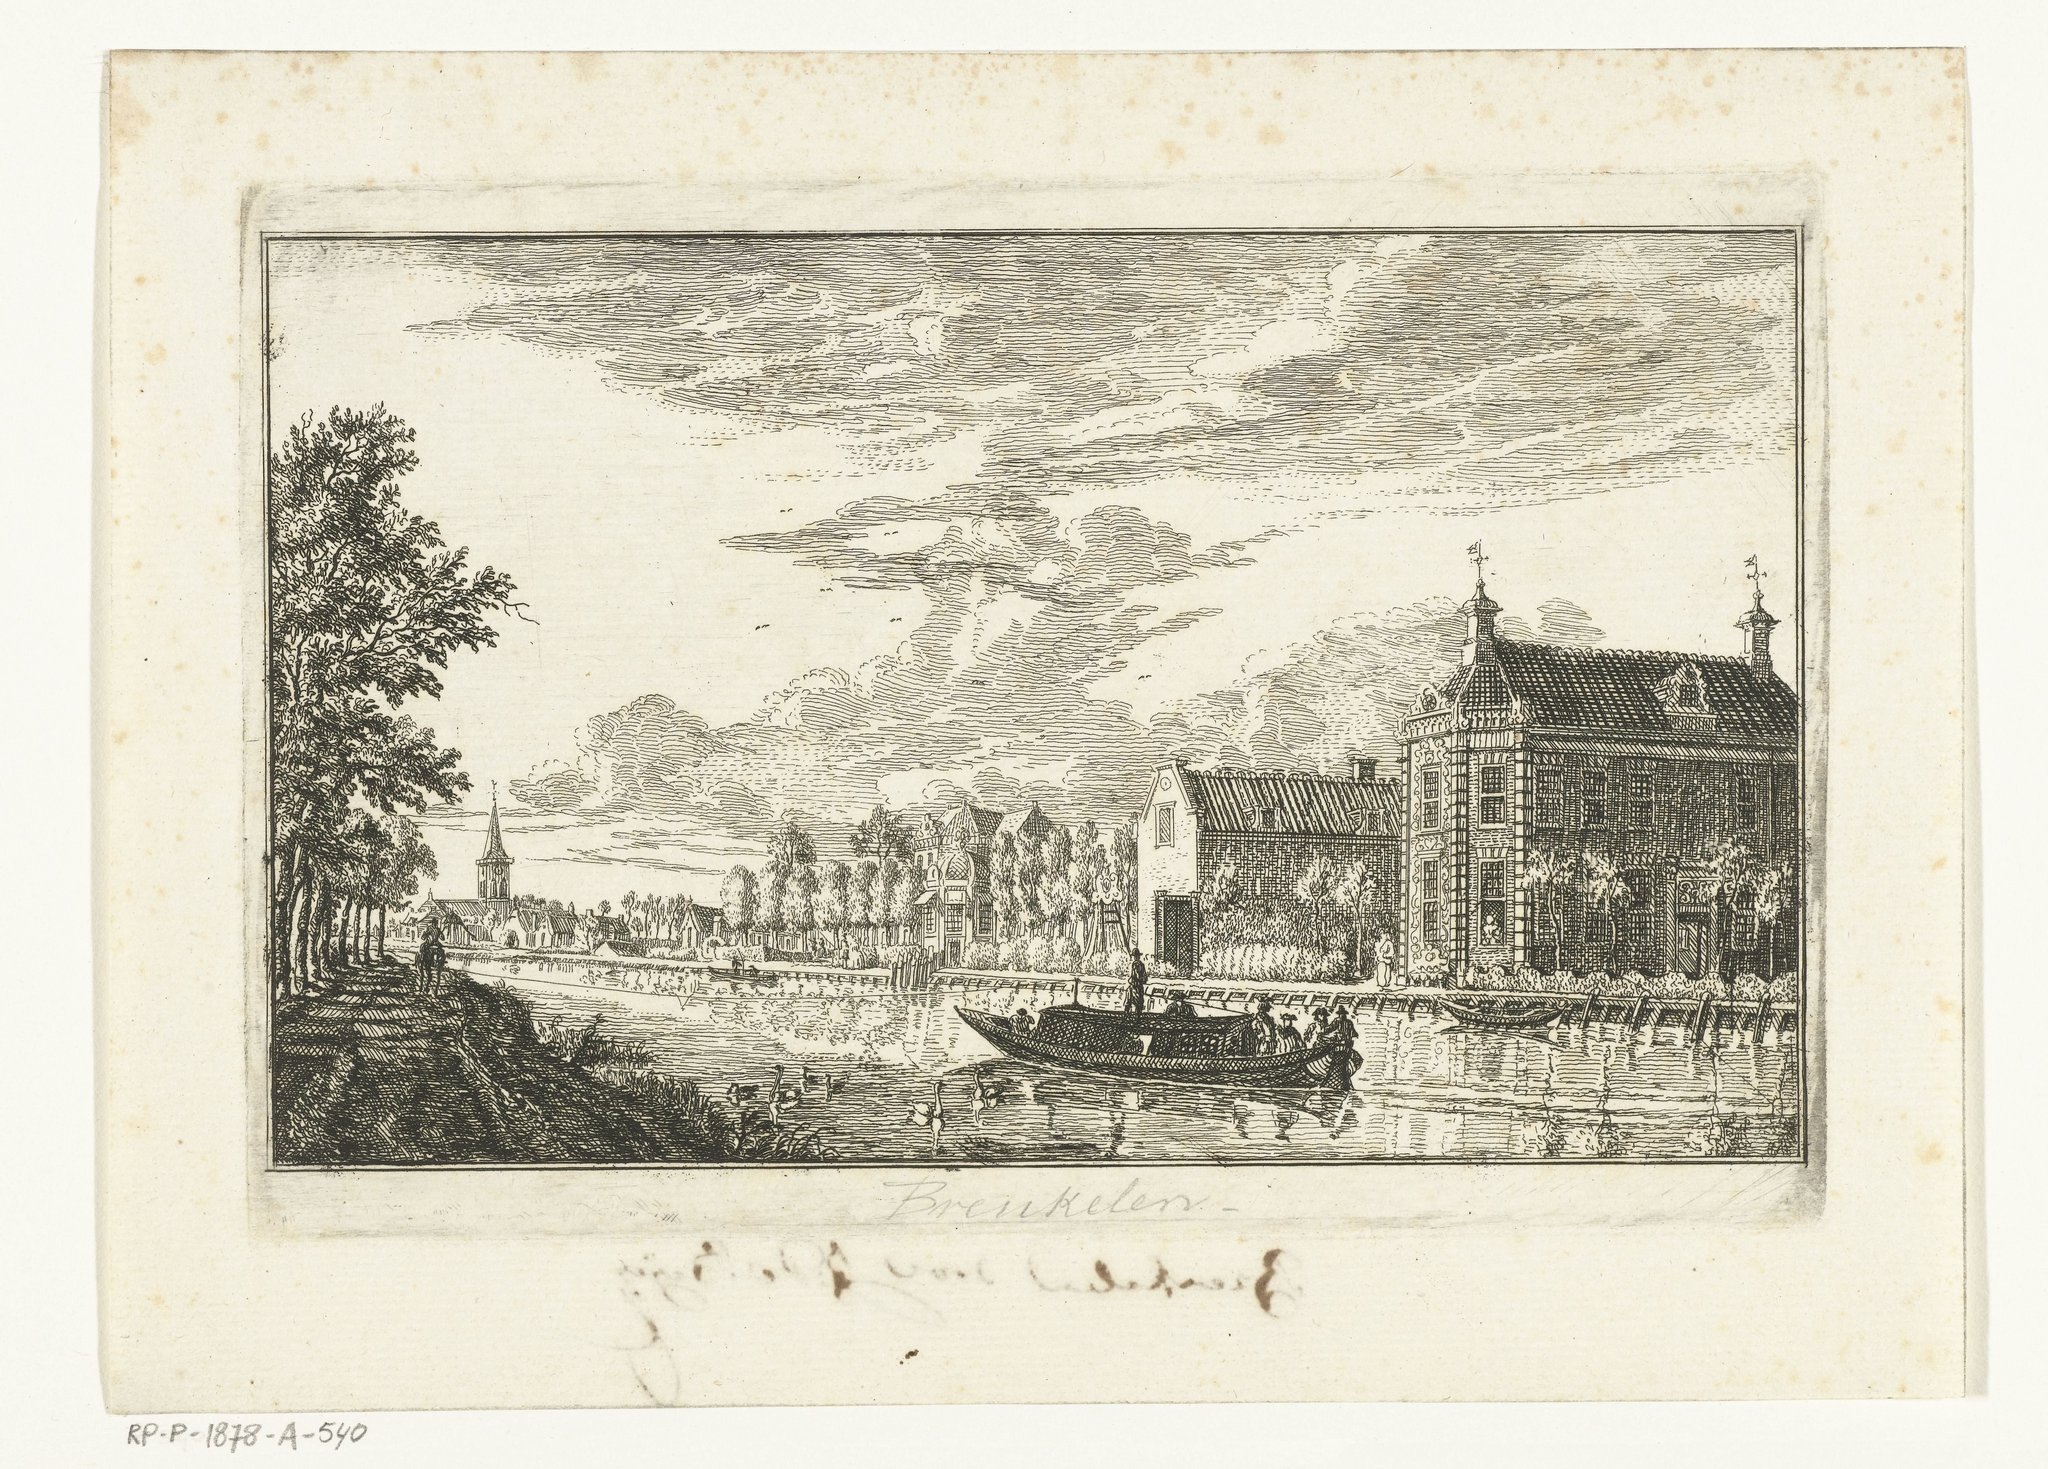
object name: print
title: Dorpsgezicht te Breukelen met trekschuit op de Vecht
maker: jan de beijer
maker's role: draughtsman, print maker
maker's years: 1703-1780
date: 1713-1780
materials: paper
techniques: etching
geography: netherlands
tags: tow-boat, towing-barge, towing path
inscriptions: inscription: ‘Breukelen door J: de Beijer’, collector's mark: Lugt 2228